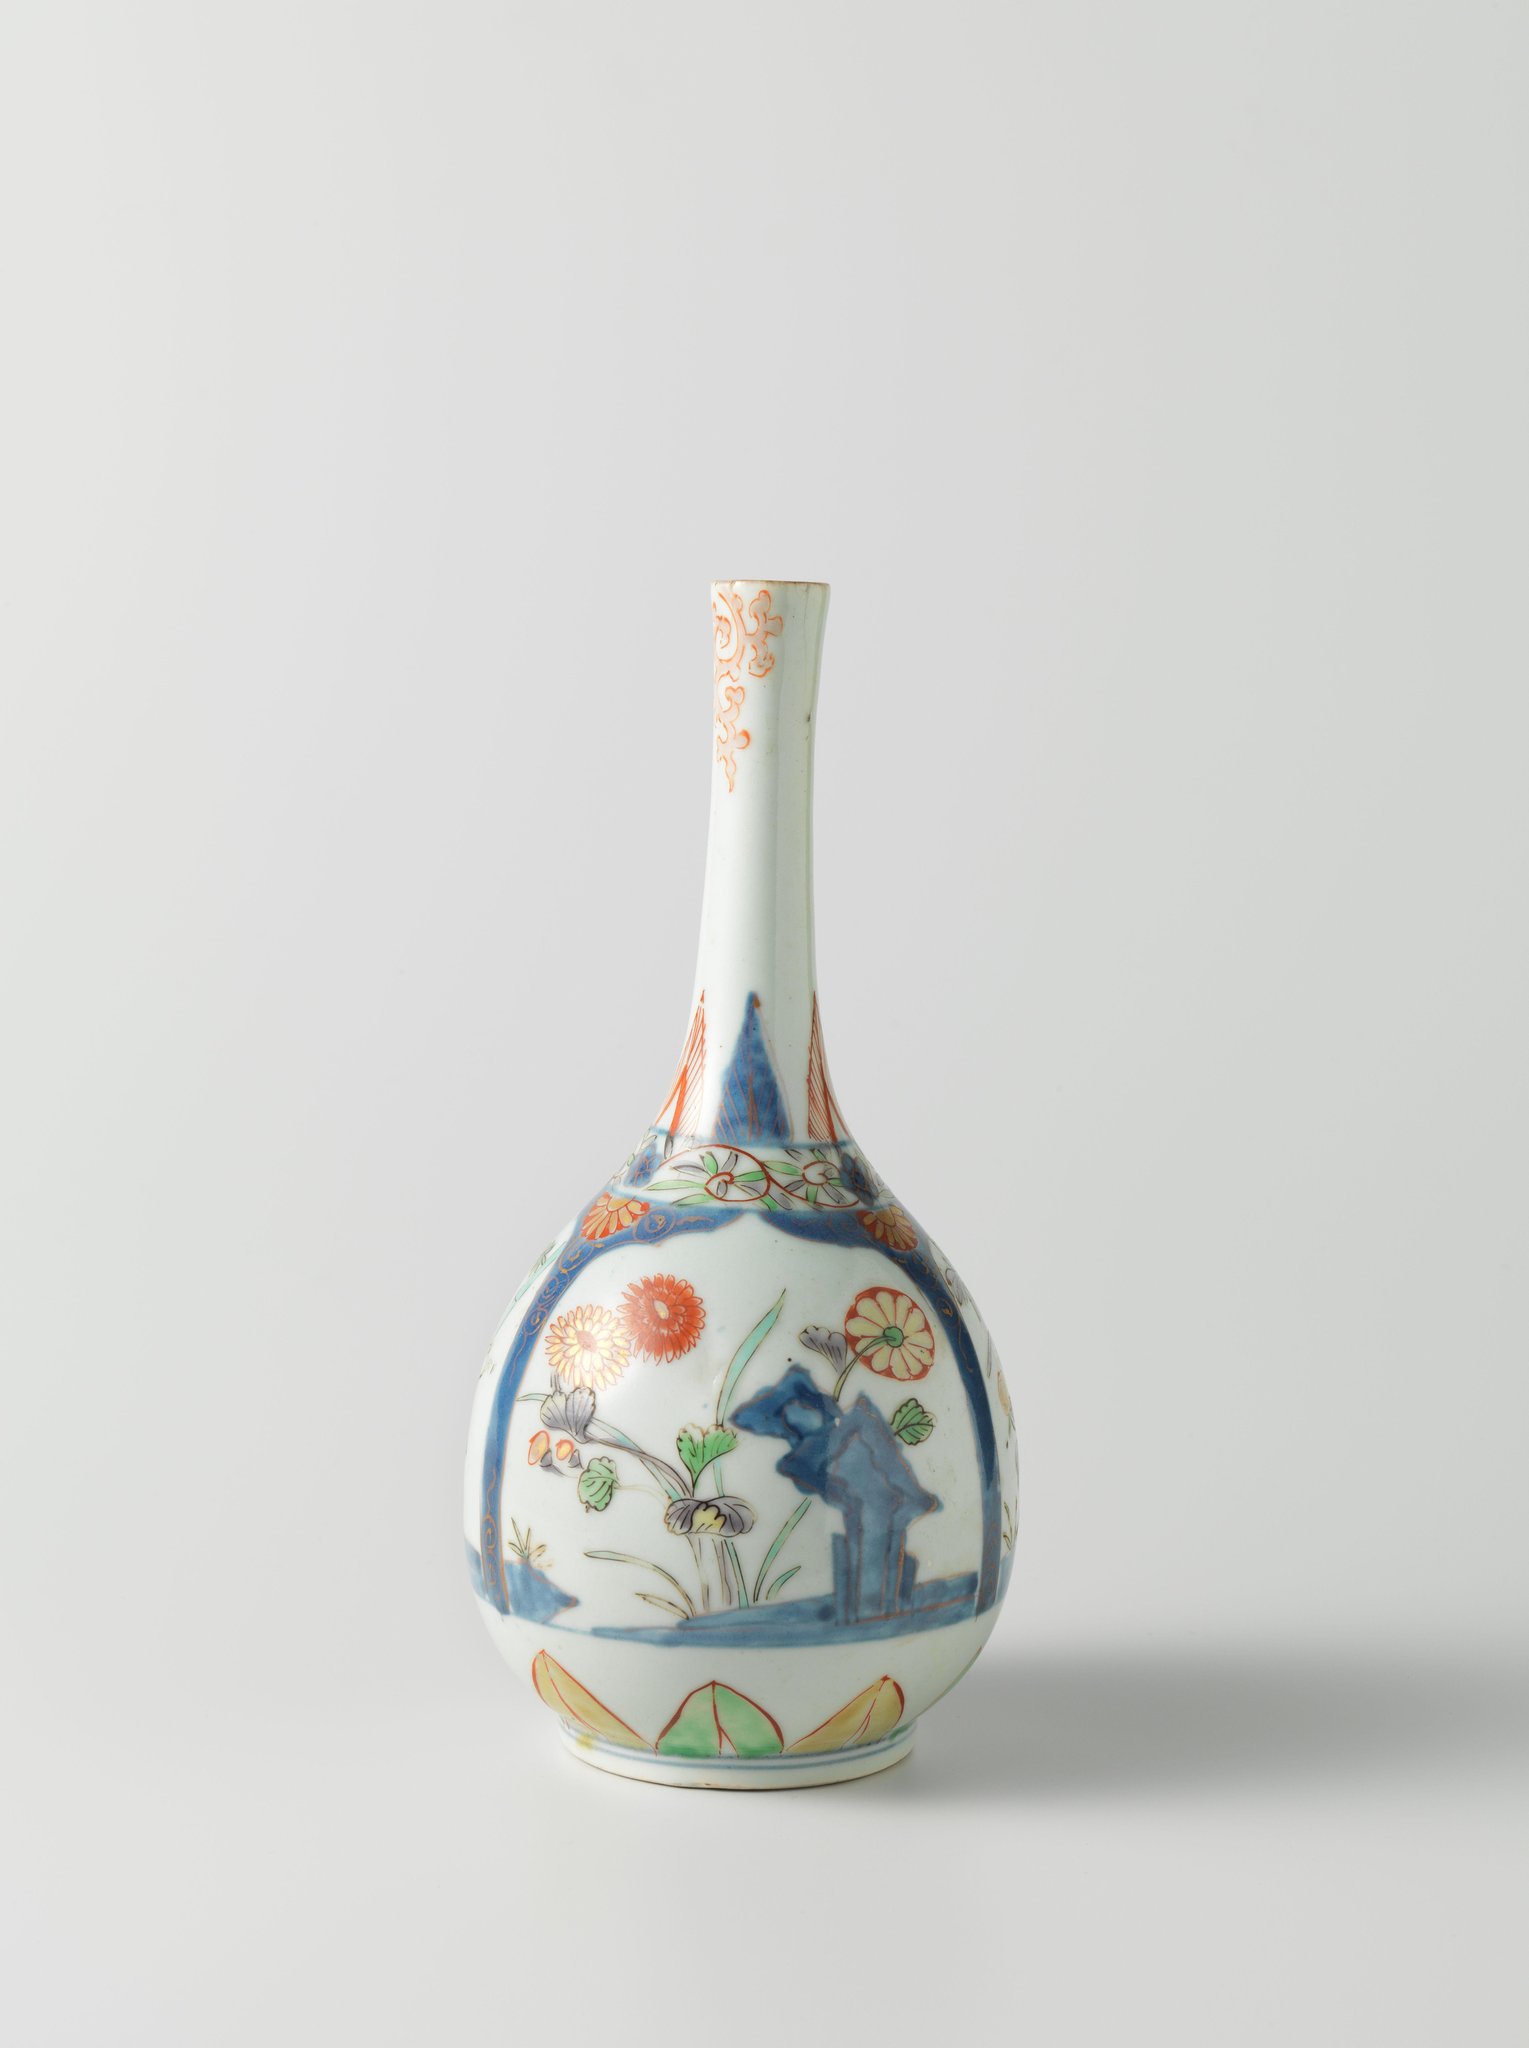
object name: bottle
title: Jug and Two Bottles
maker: Anonymous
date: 1700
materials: cobalt, glaze, gold, paint, porcelain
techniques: firing, gilding, turning, vitrification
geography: arita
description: The jug was made in Japan, but its form is European. Moreover, the decorative painting – a landscape with figures – was probably based on a jug from Delft. In this way, Japanese potters catered to the wishes of Dutch enthusiasts. The bottles are painted with multicoloured enamel. This colourful export ware was in great demand in the Netherlands from the end of the 17th century.